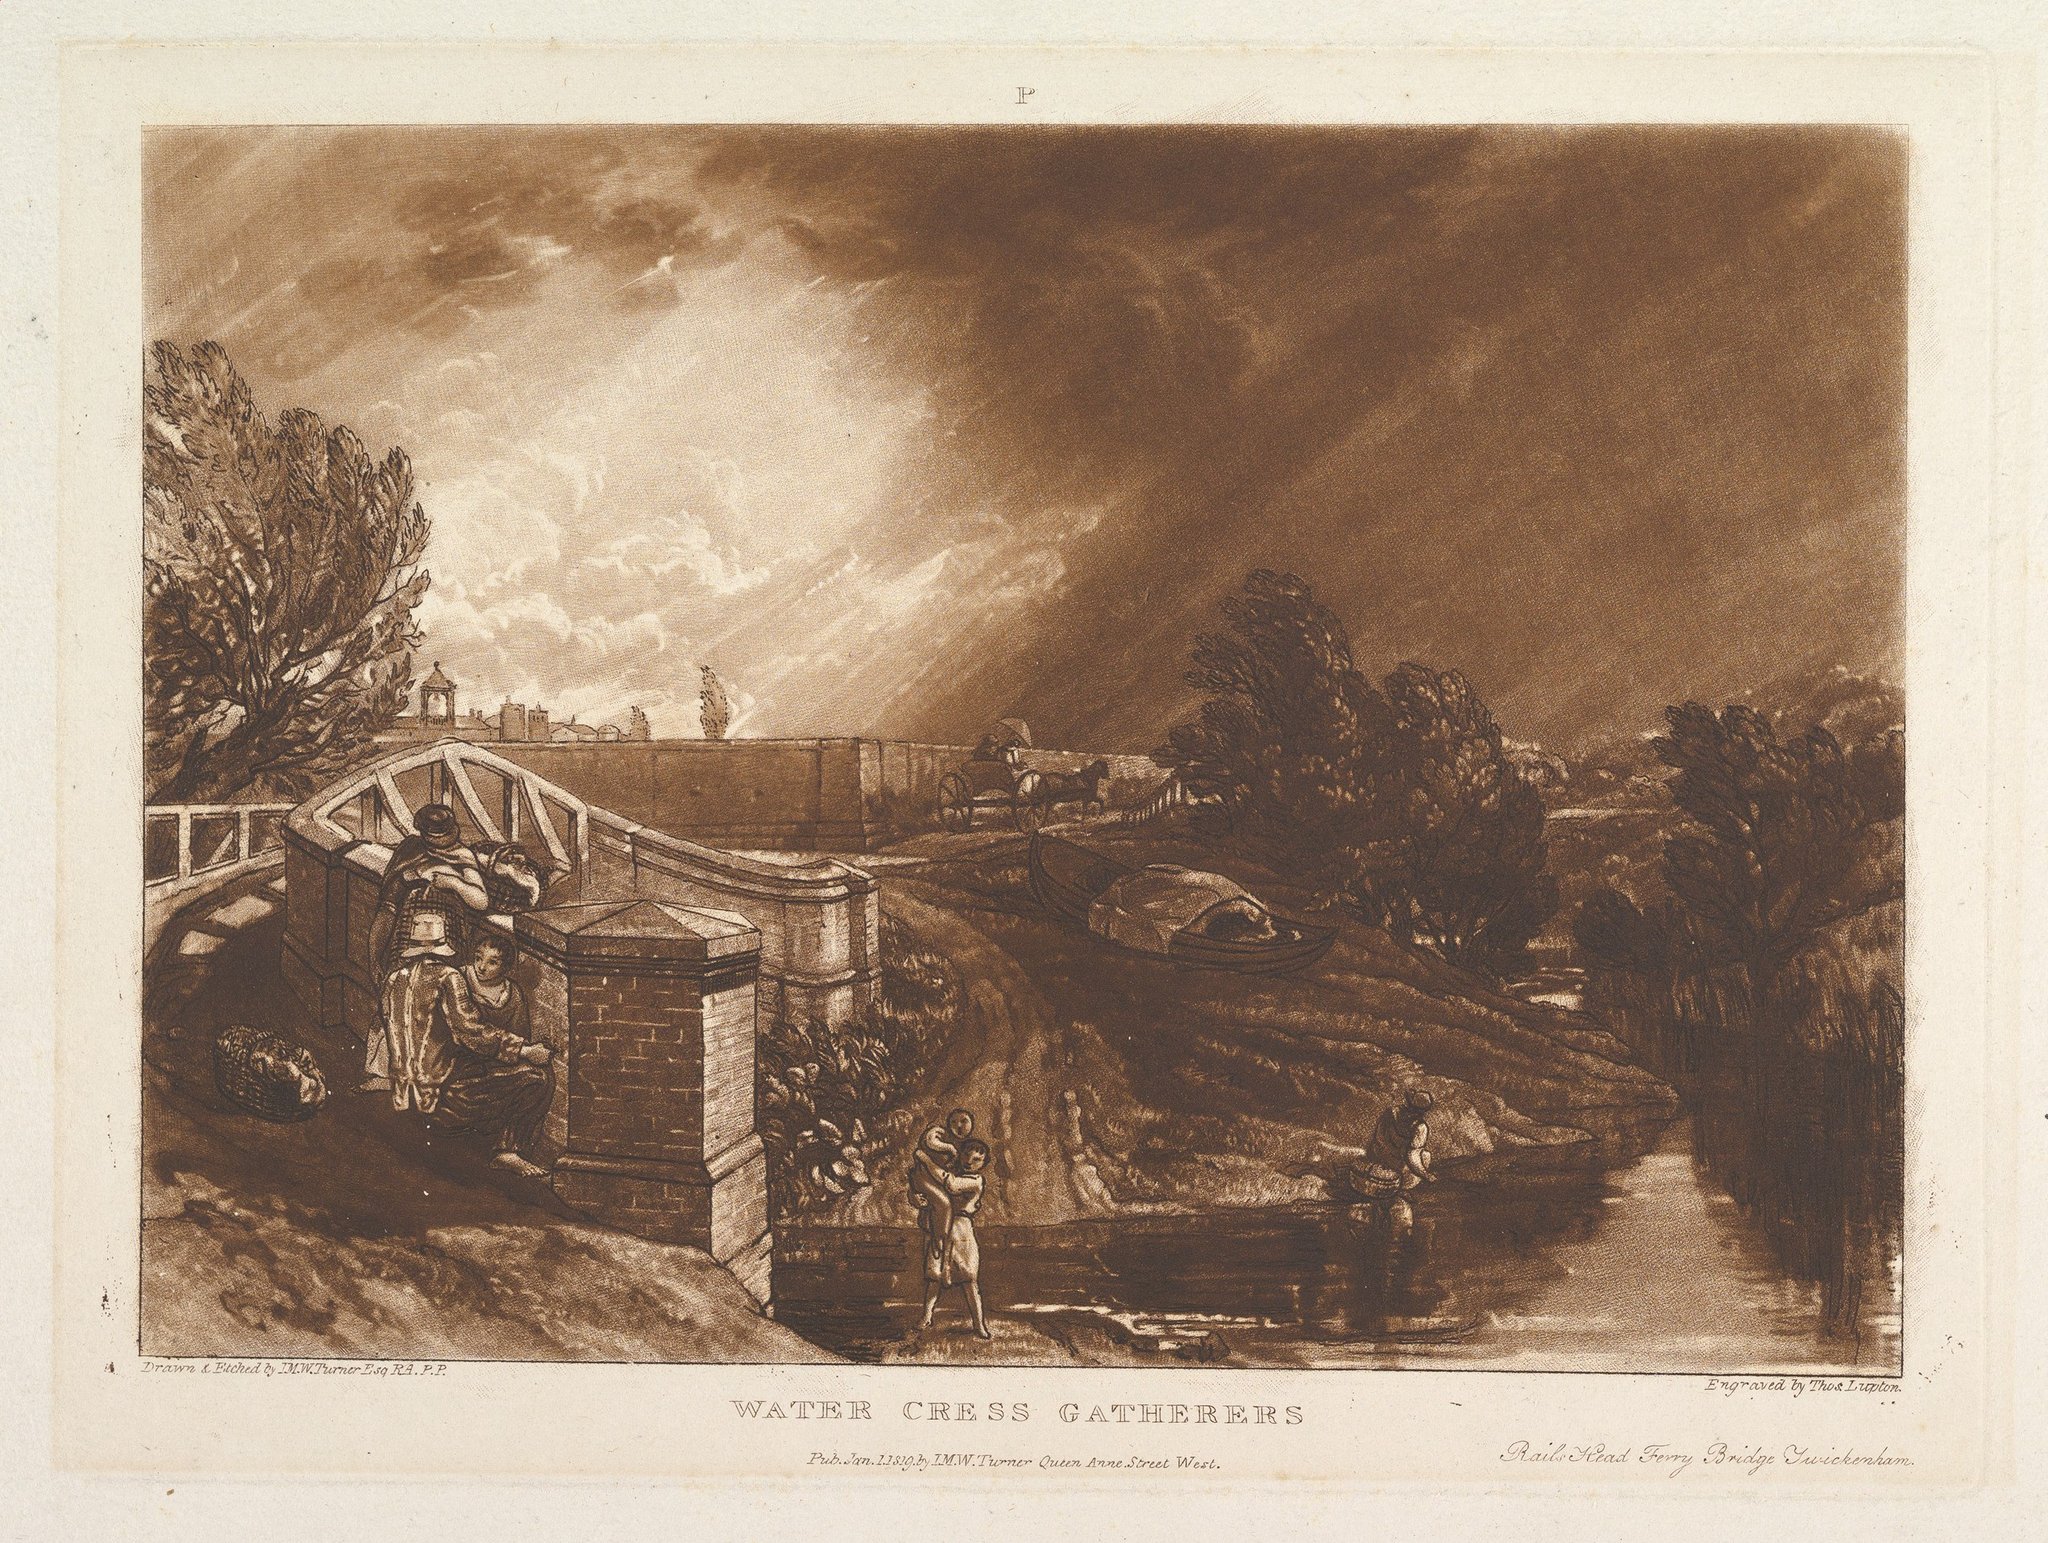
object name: print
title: Water Cress Gatherers, Rails Head Ferry Bridge, Twickenham, part XIII, plate 62 from "Liber Studiorum"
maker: joseph mallord william turner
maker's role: artist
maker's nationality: british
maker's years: 1775-1851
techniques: etching, mezzotint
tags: bridges,children,landscapes